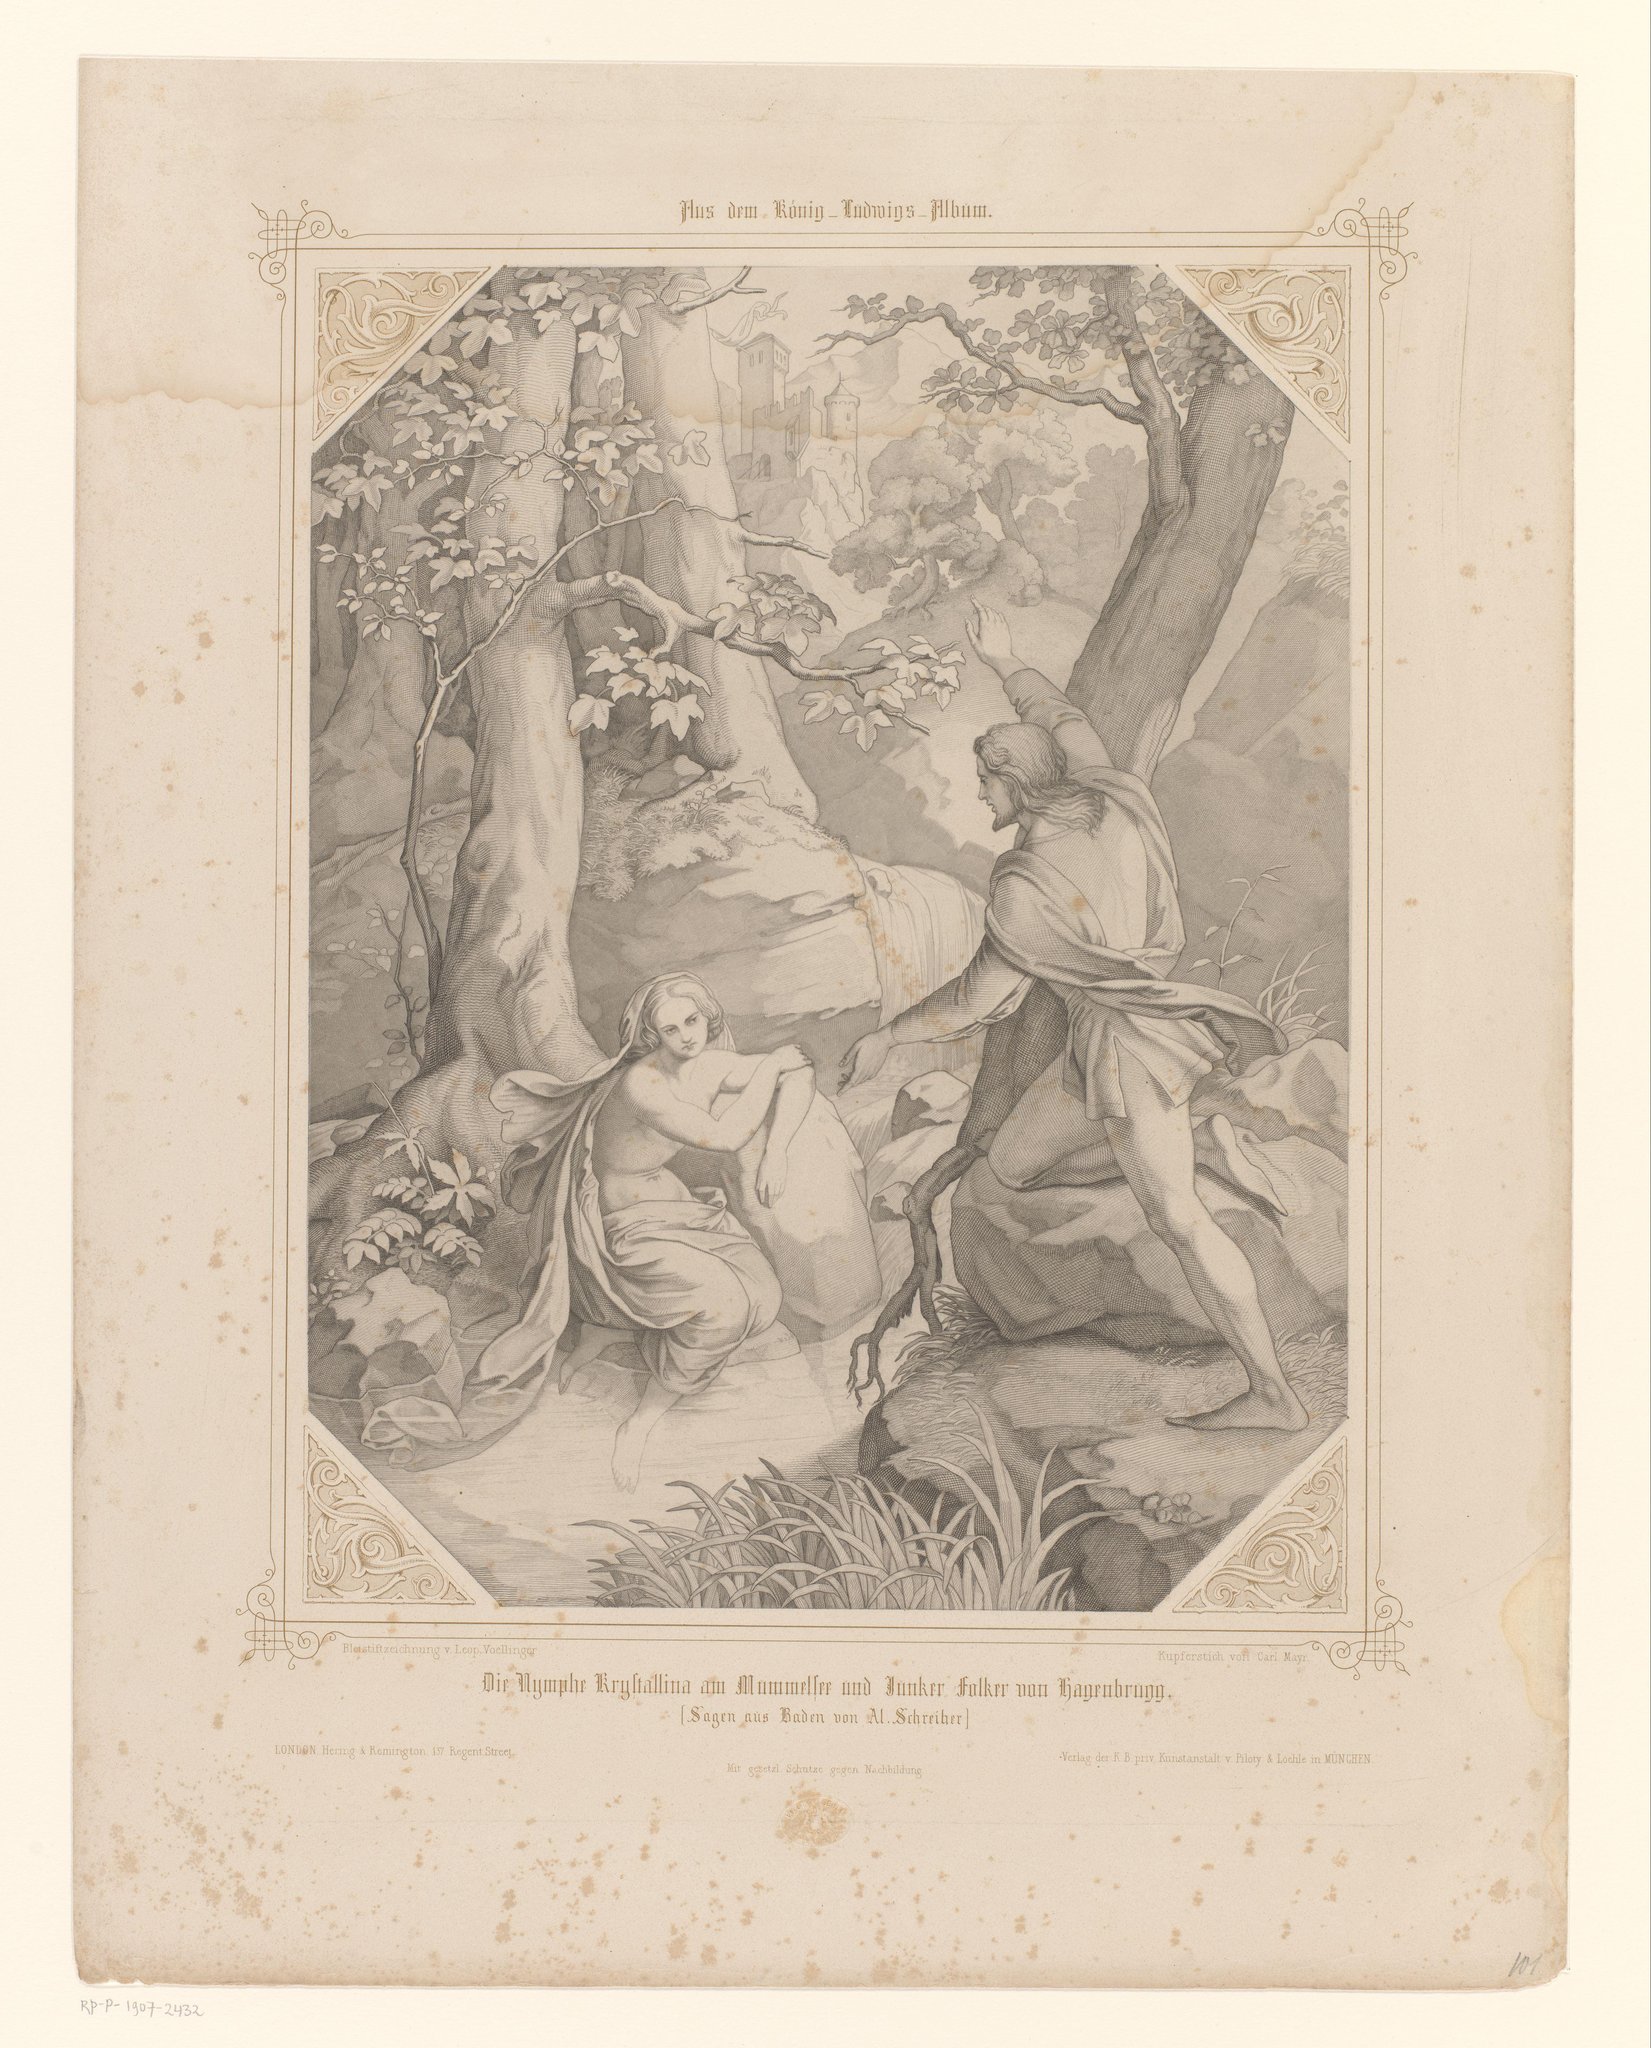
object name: print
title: König-Ludwigs Album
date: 1850-1859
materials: paper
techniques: lithograph, engraving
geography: london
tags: lodewijk i (koning van beieren), castle, naiads, river- and spring-nymphs; usually carrying an urn; 'naiadi, ninfe de' fiumi' (ripa)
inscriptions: collector's mark: Lugt 2228, check stamp: ‘Piloty & Loehle Munchen’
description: Prent afkomstig uit de serie 'Album Seiner Majestät des Königs Ludwig I. von Bayern', verschenen in verschillende afleveringen. De prenten gaan terug op het album dat Lodewijk I van Beieren op 9 oktober 1850 kreeg overhandigd van verschillende kunstenaars.